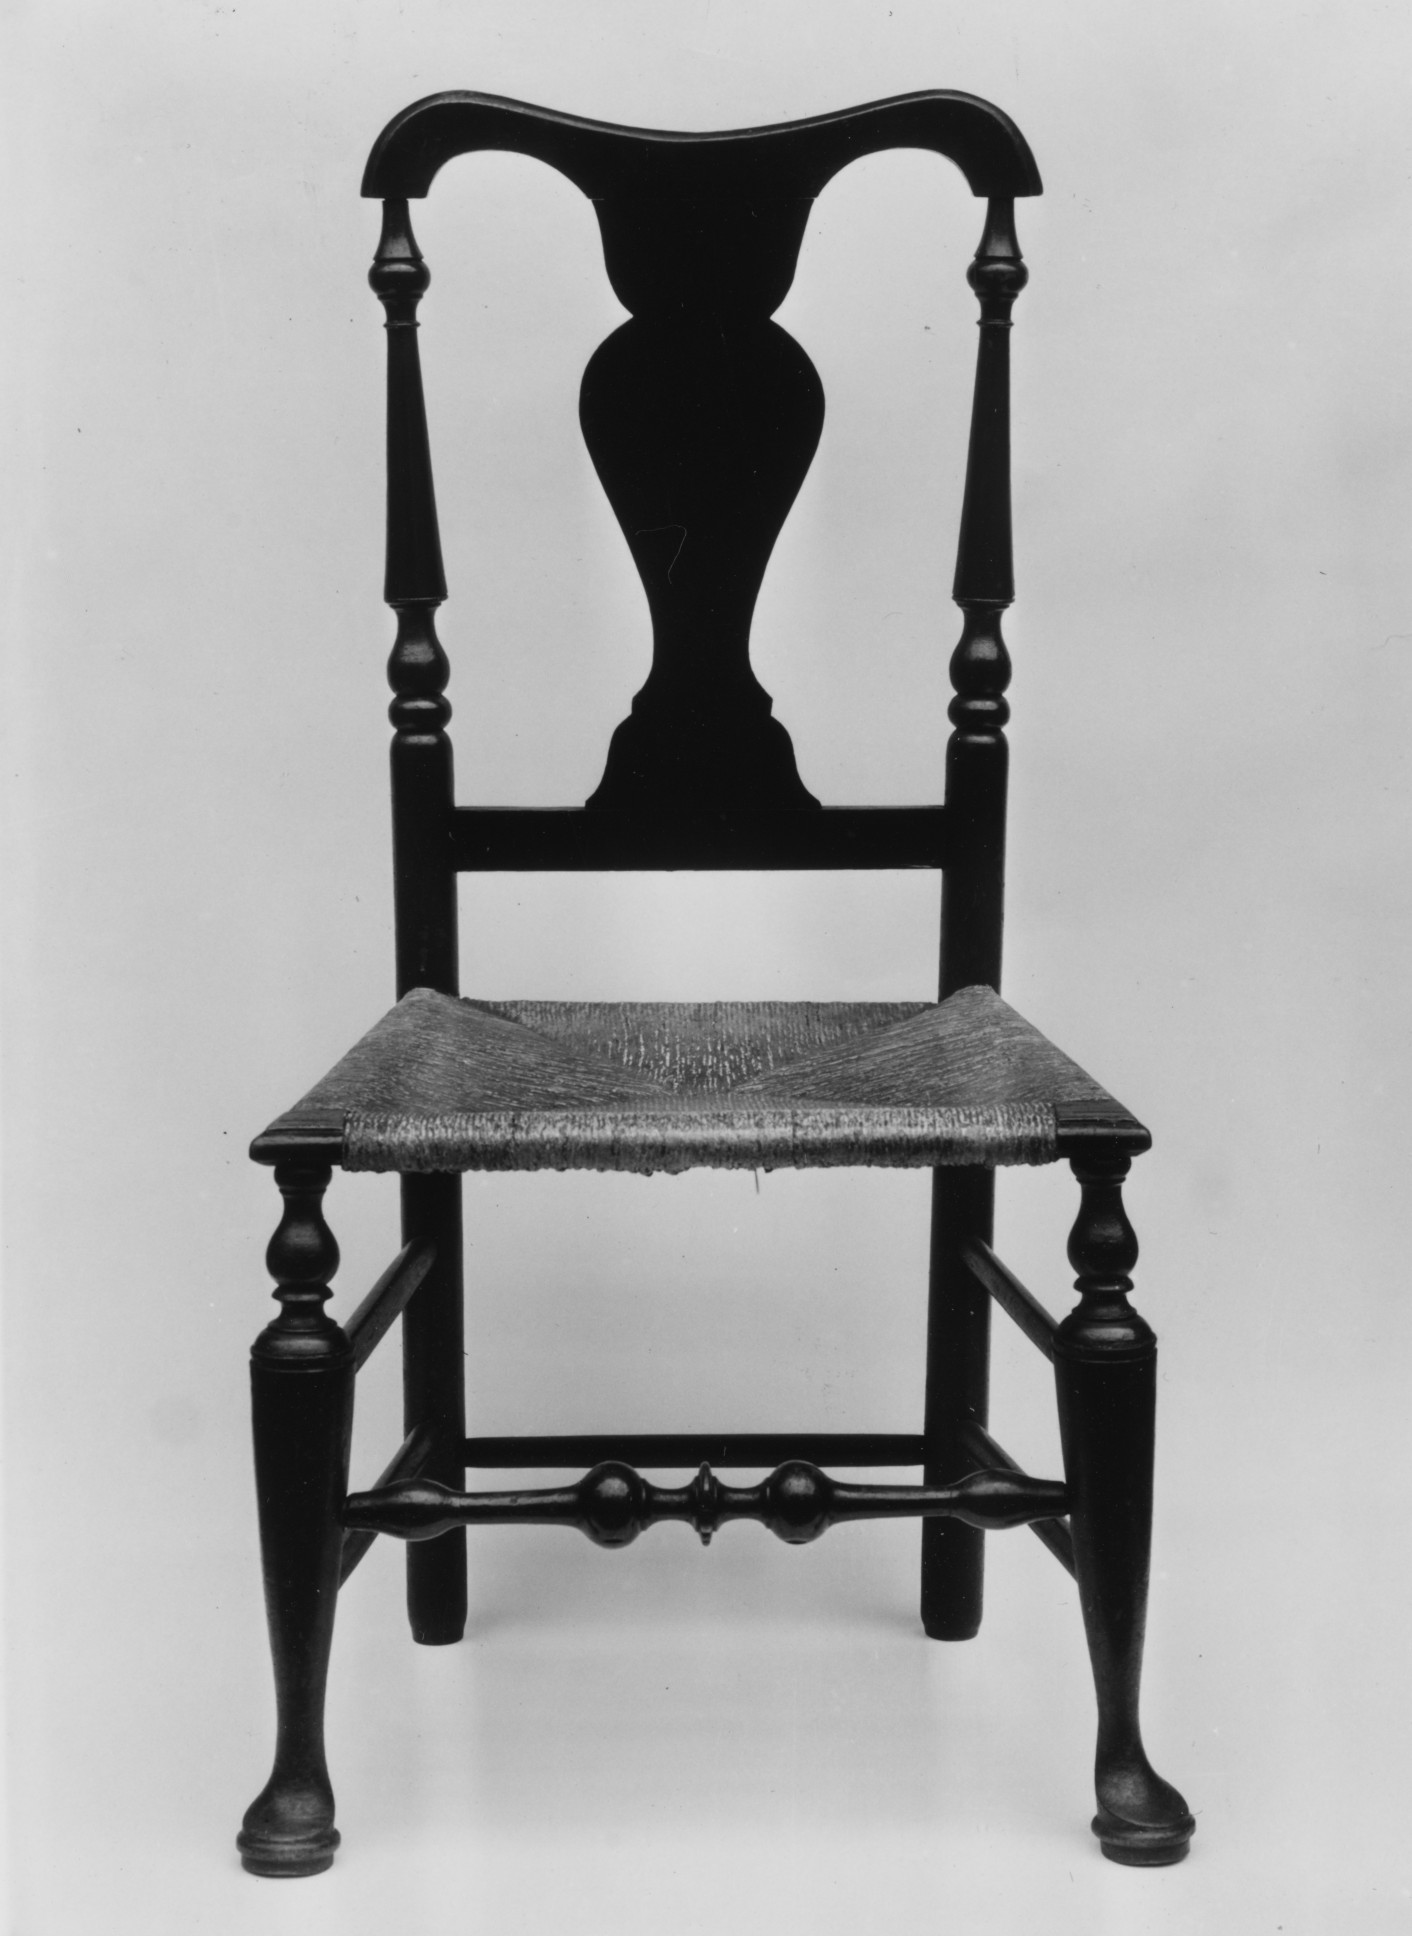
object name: side chair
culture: american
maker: michael smith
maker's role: maker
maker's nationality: american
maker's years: 1736-1836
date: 1780-1800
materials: wood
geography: united states